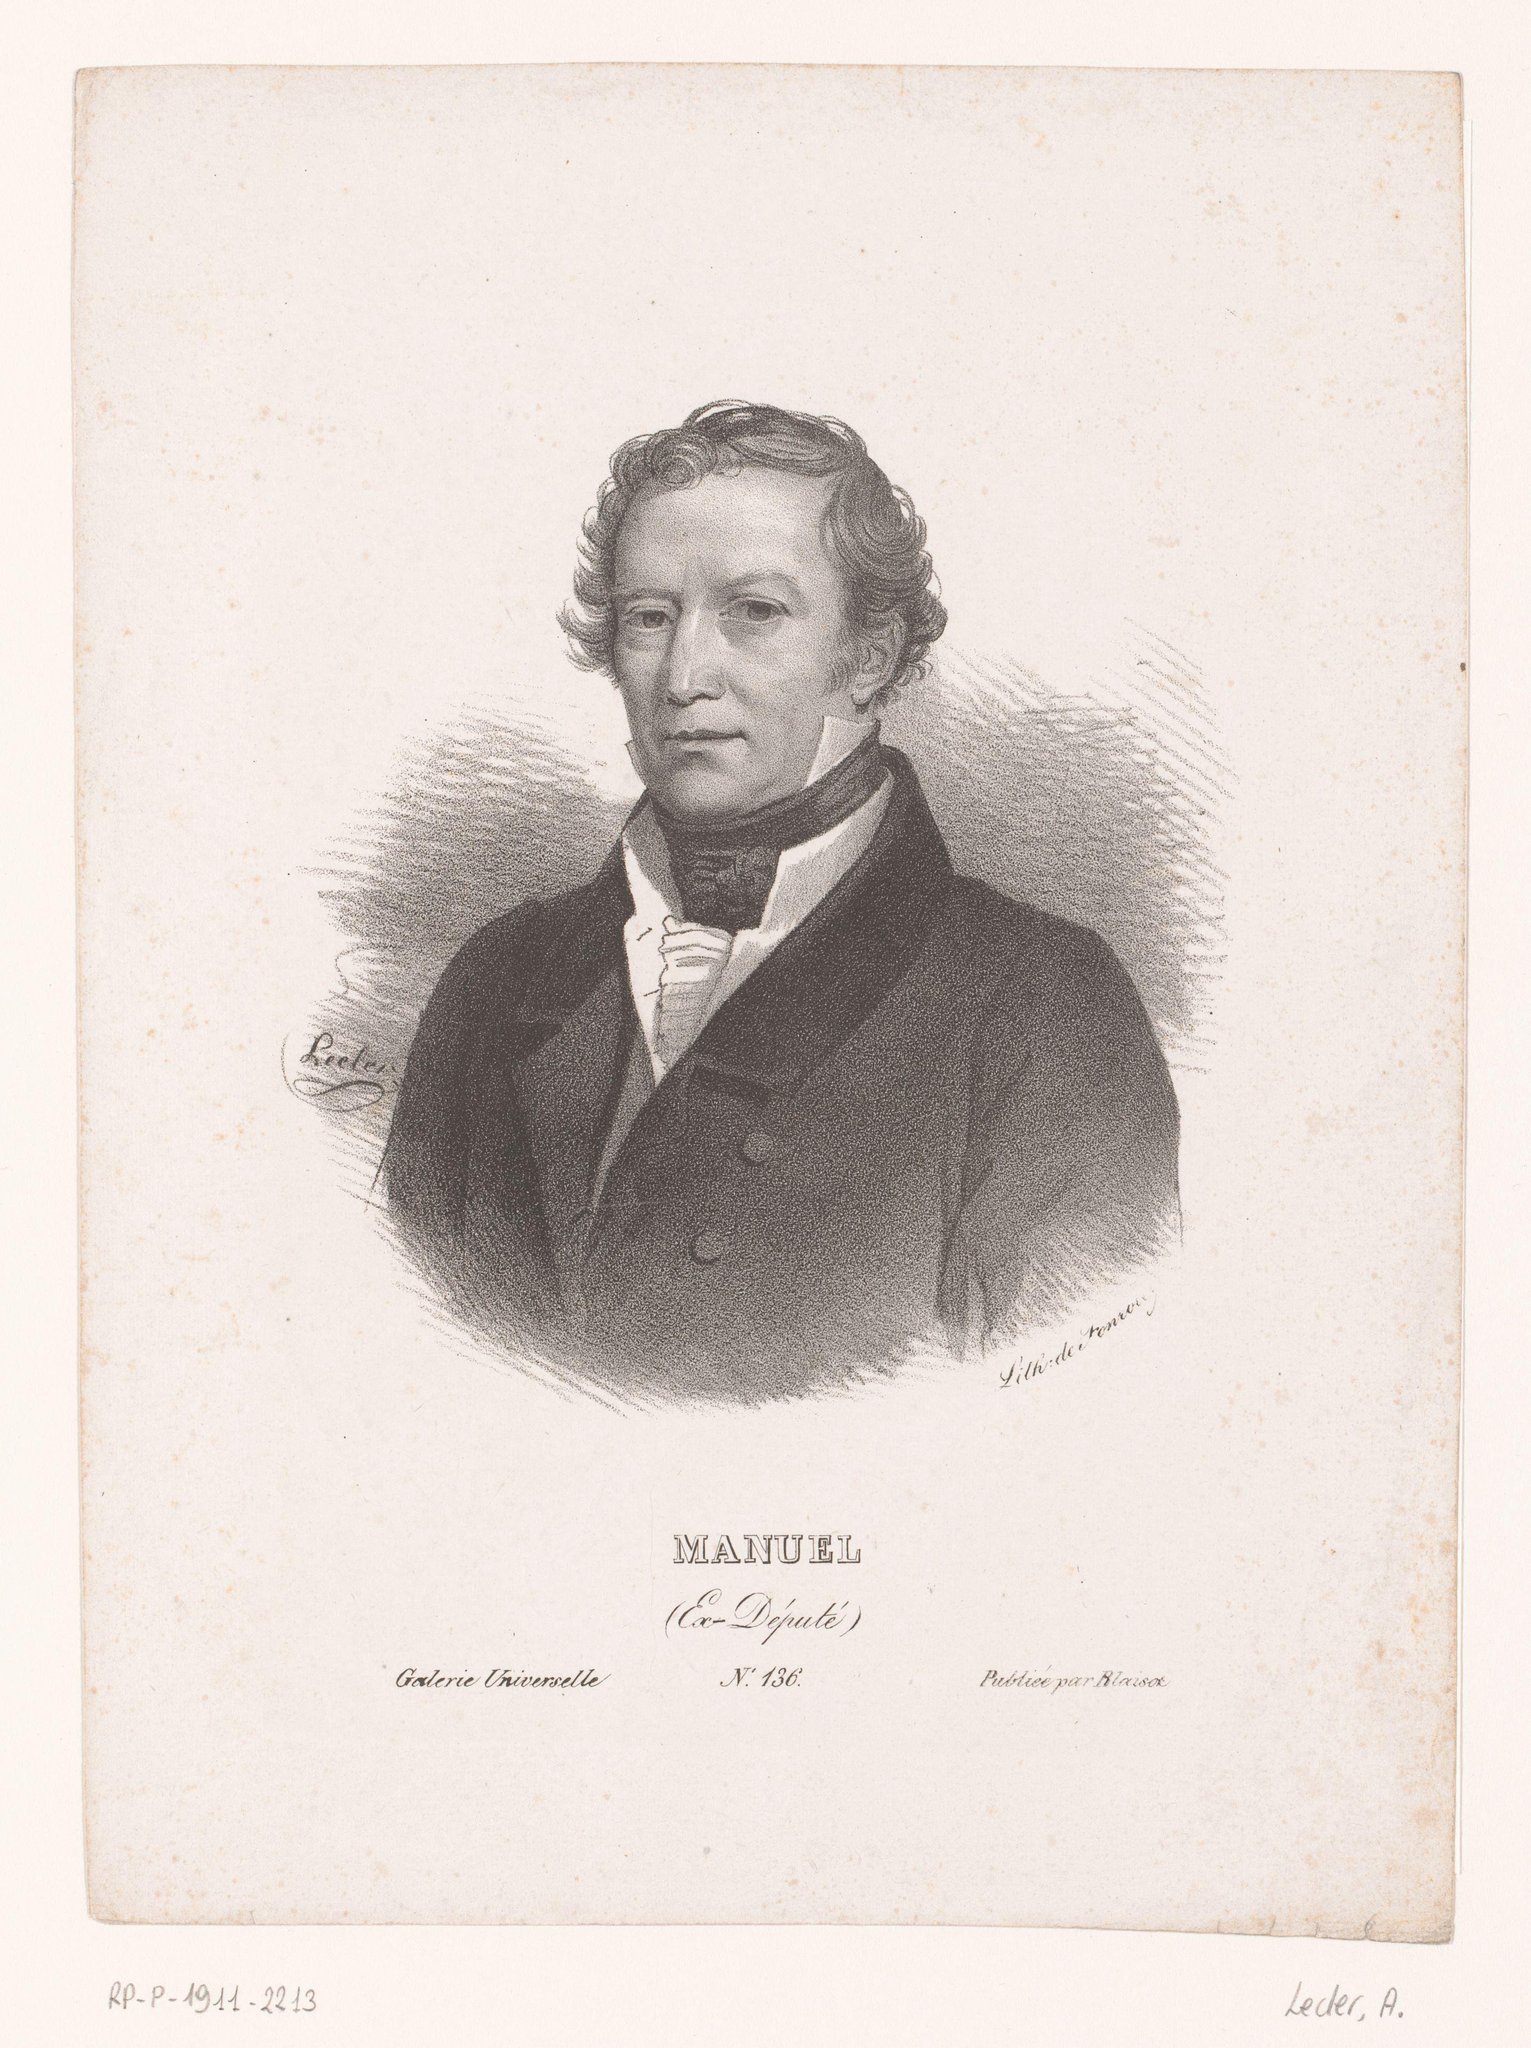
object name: print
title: Manuel (Ex-Député)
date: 1829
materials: paper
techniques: lithograph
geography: paris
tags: historical persons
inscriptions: collector's mark: Lugt 2228a